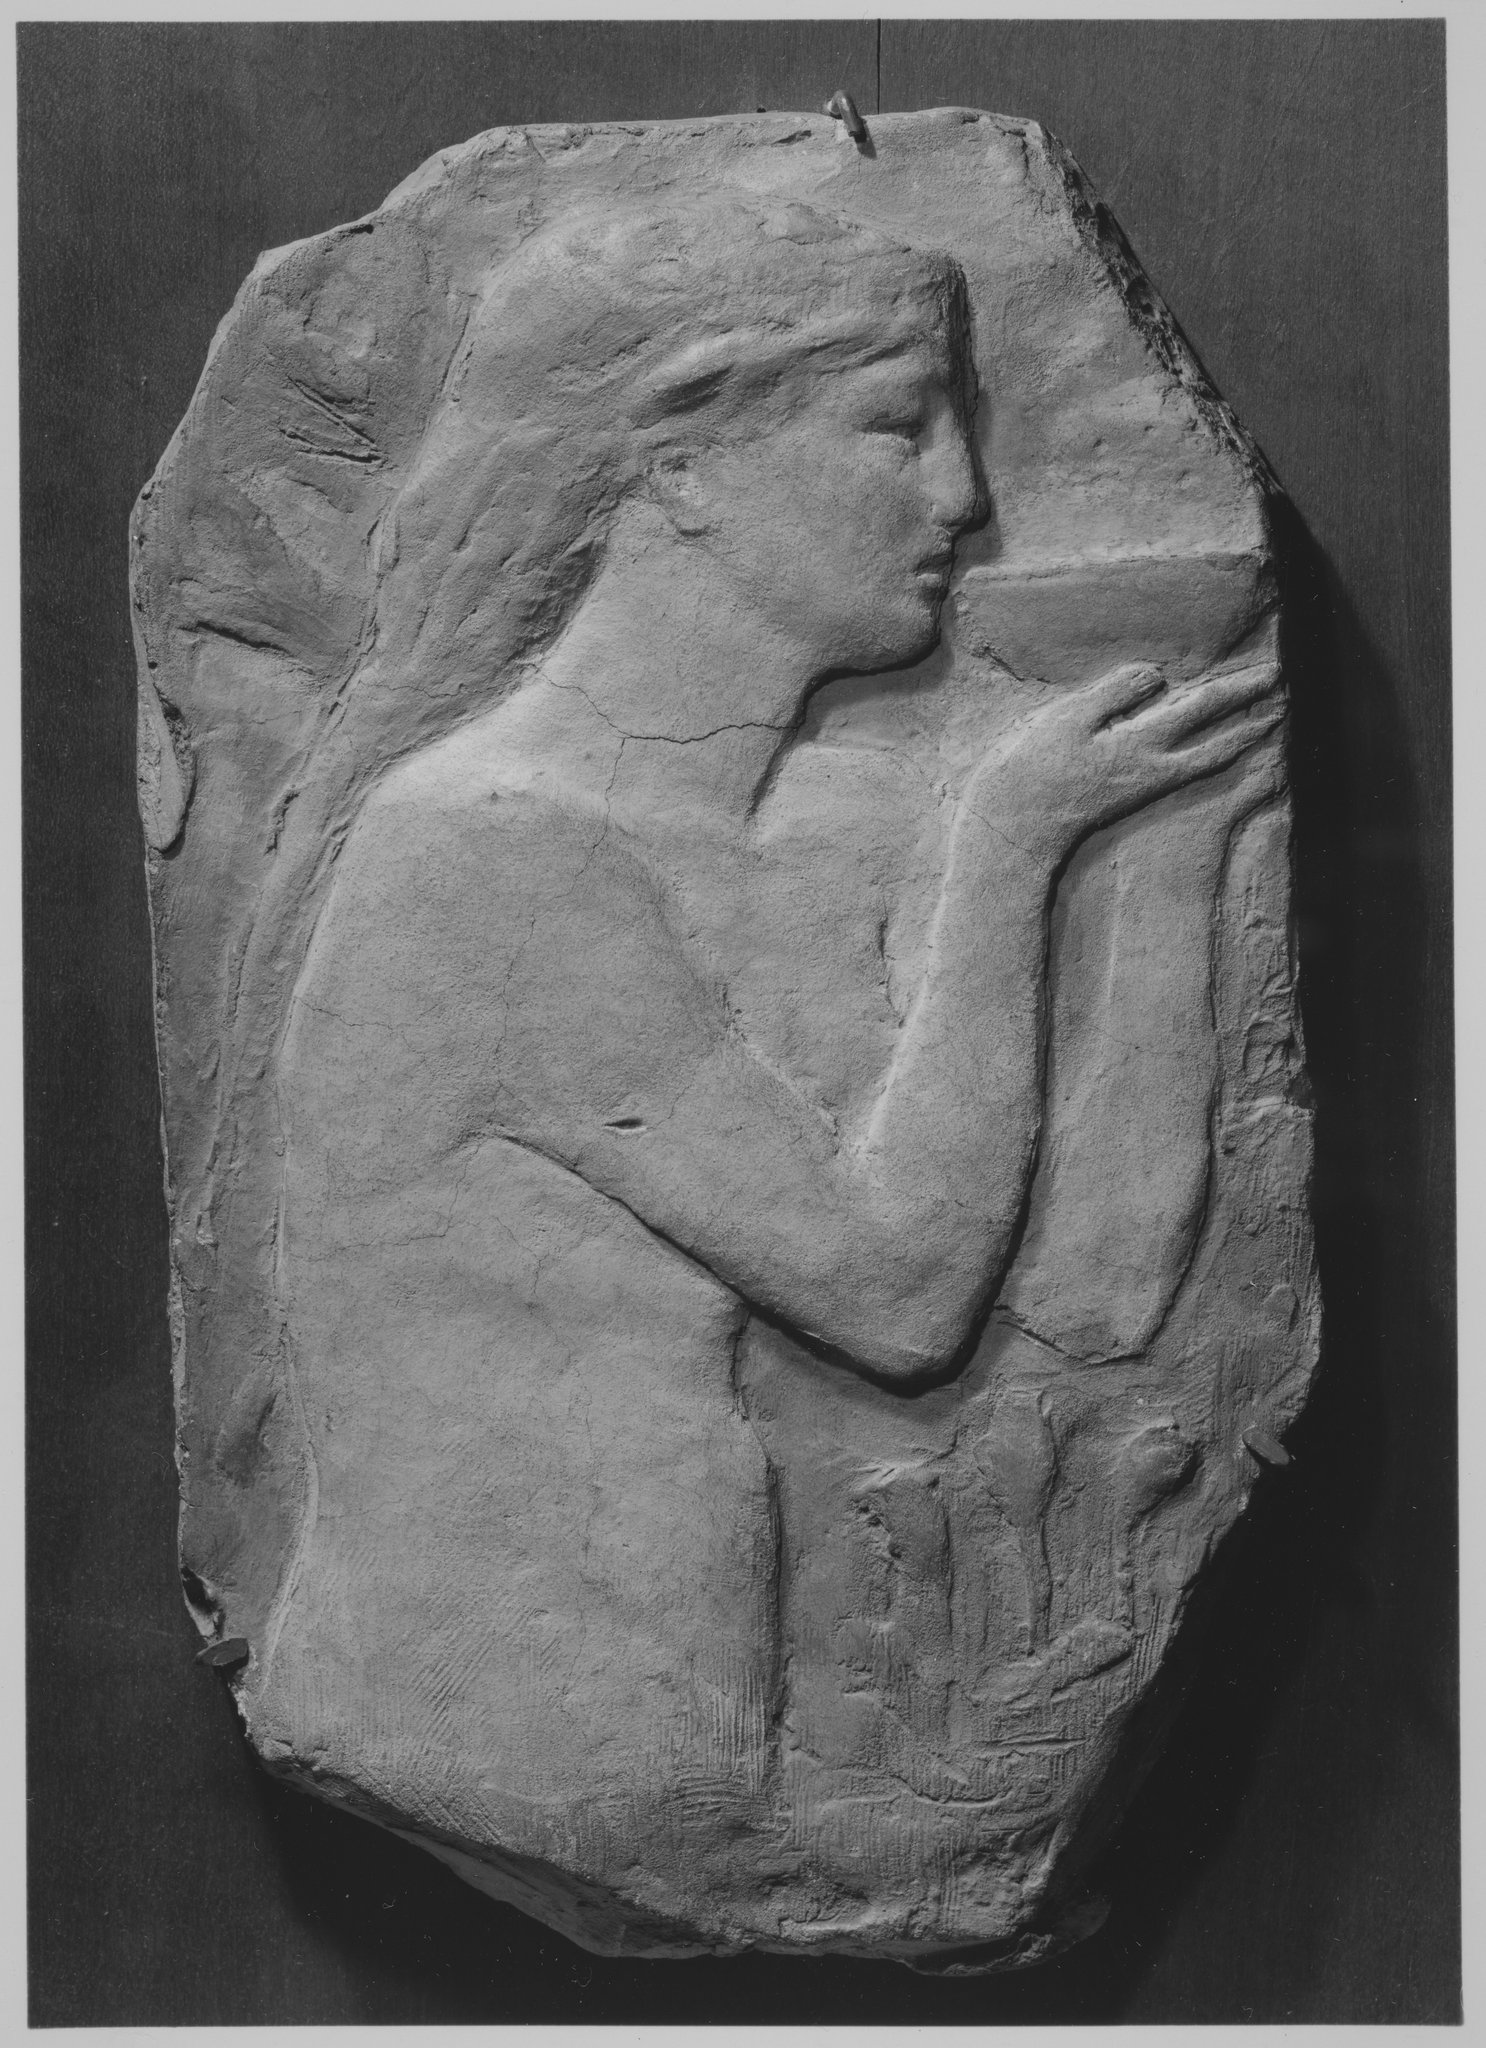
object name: relief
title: Young woman holding libation cup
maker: césar-isidore-henry cros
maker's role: maker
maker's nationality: french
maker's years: 1840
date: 1891-1907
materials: terracotta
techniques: painting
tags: profiles,women